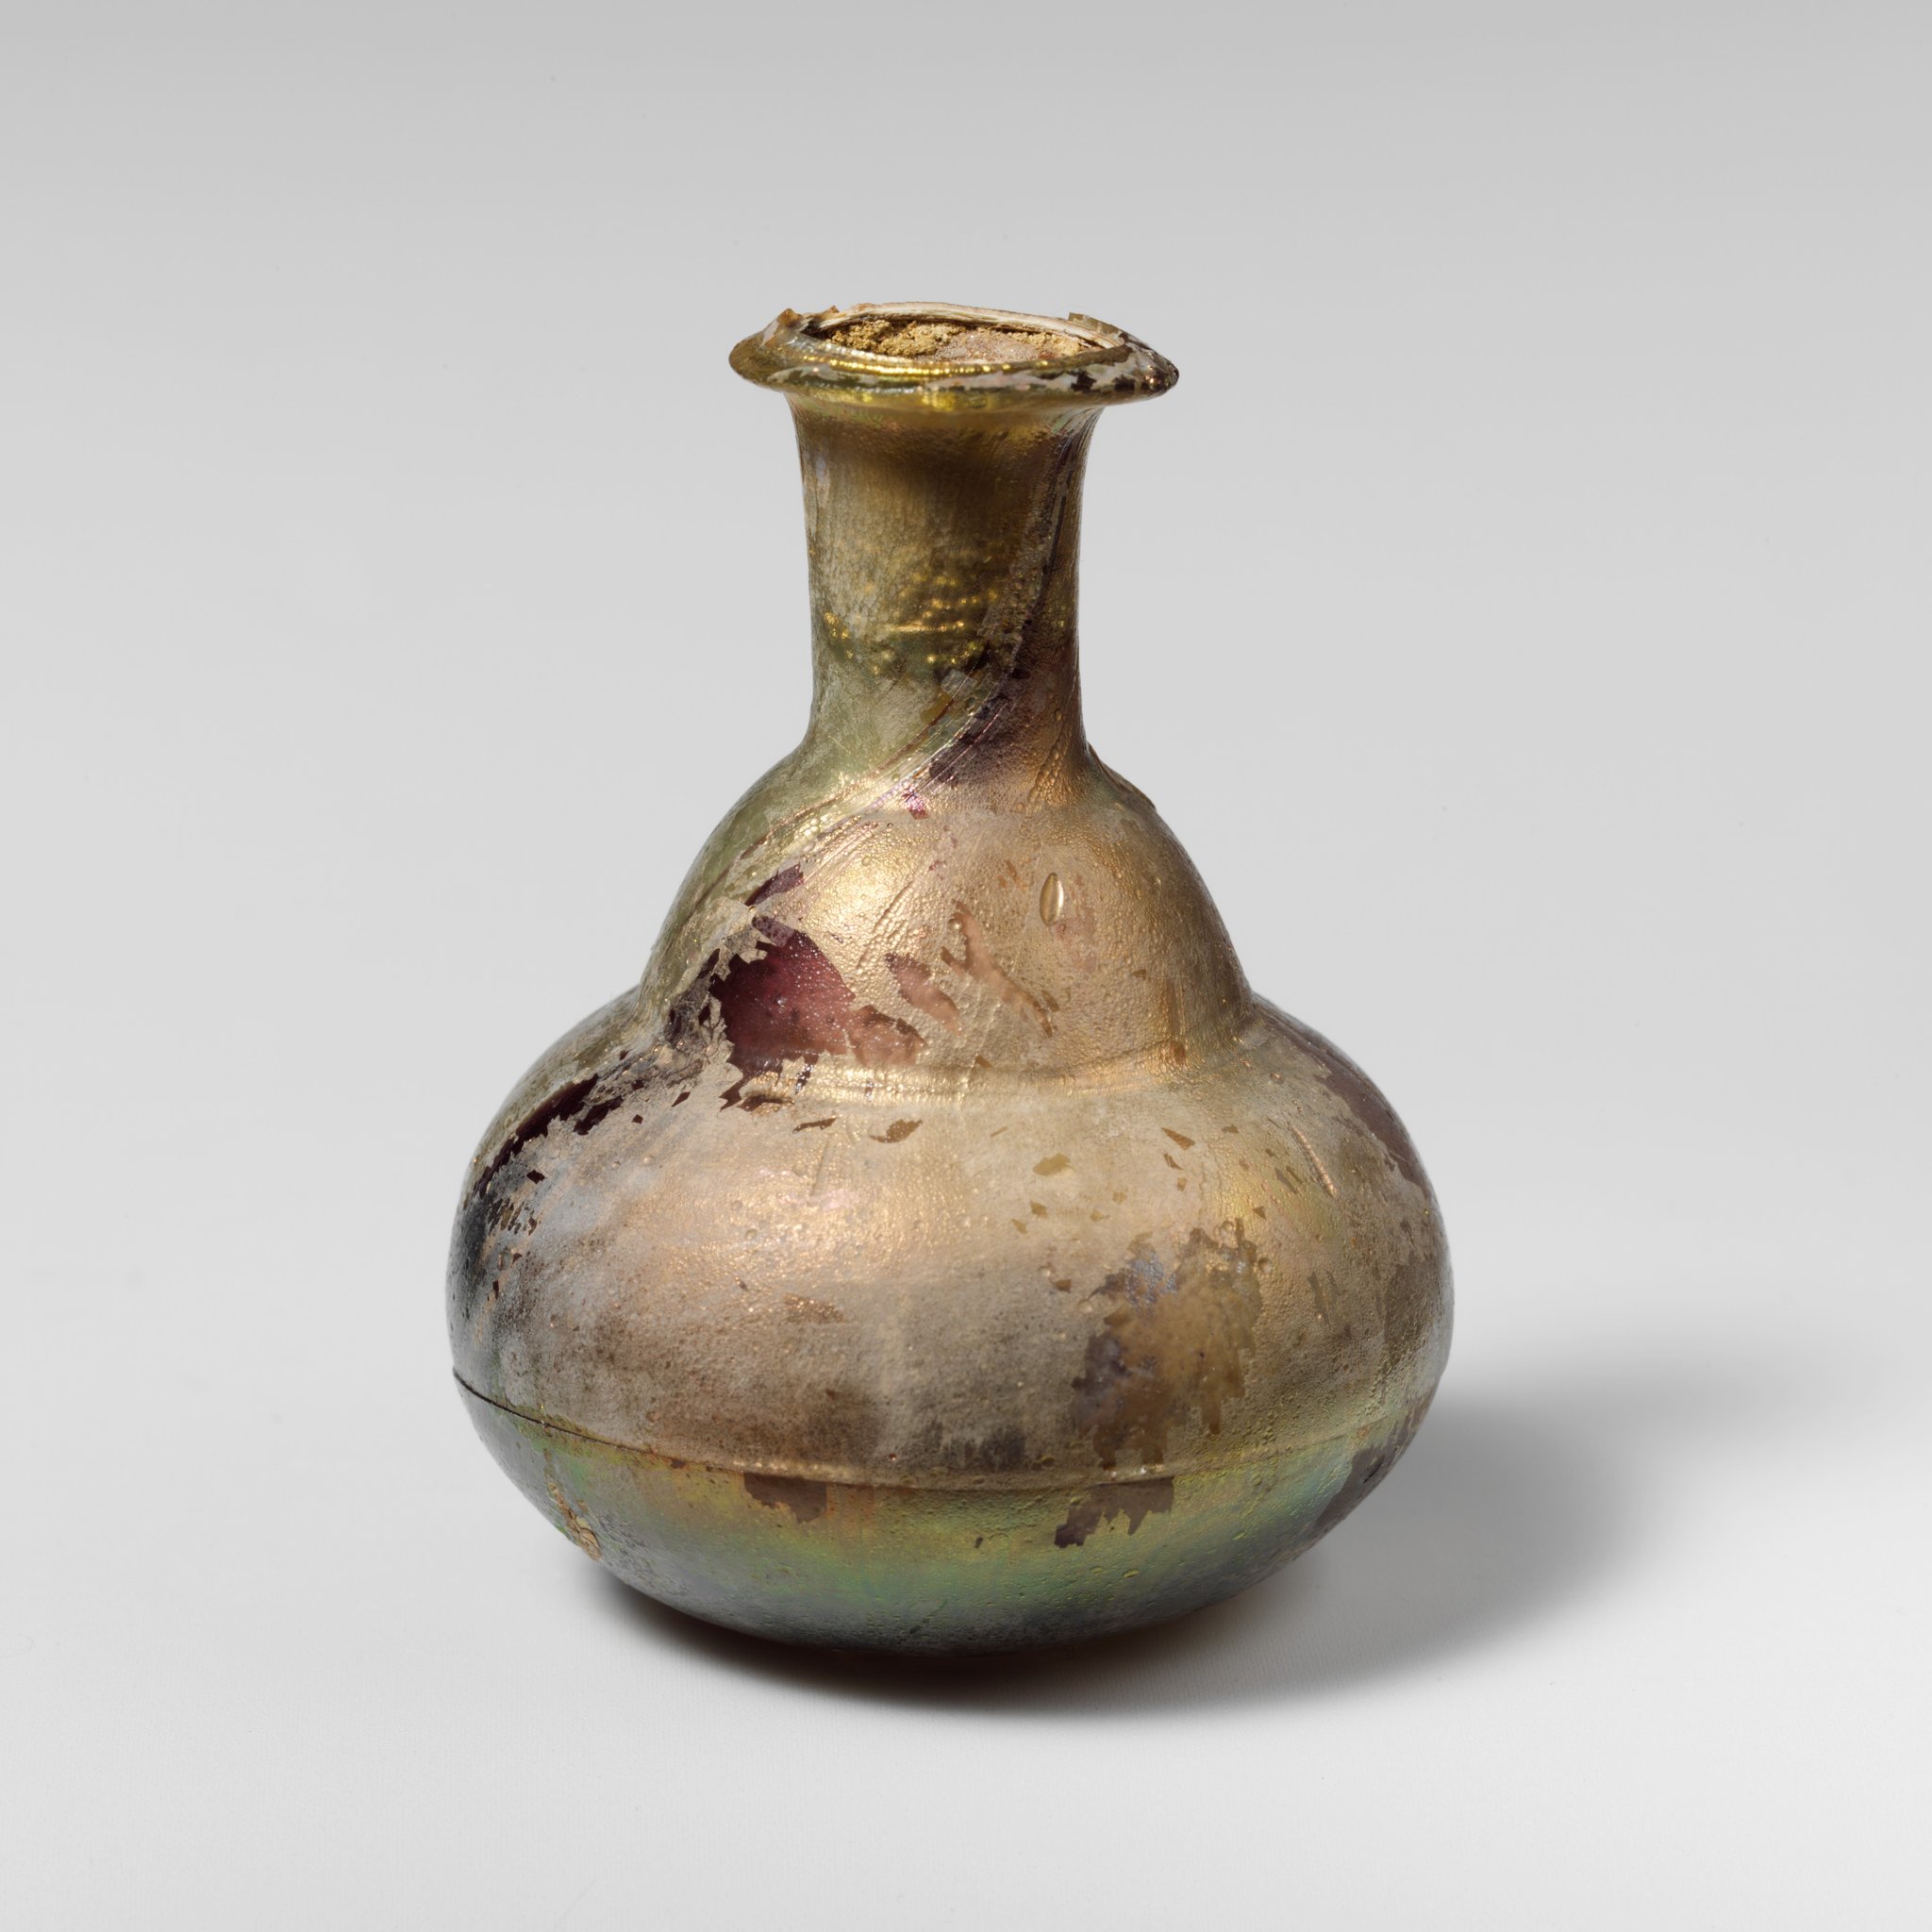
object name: perfume bottle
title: Glass perfume bottle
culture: roman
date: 1-100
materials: glass